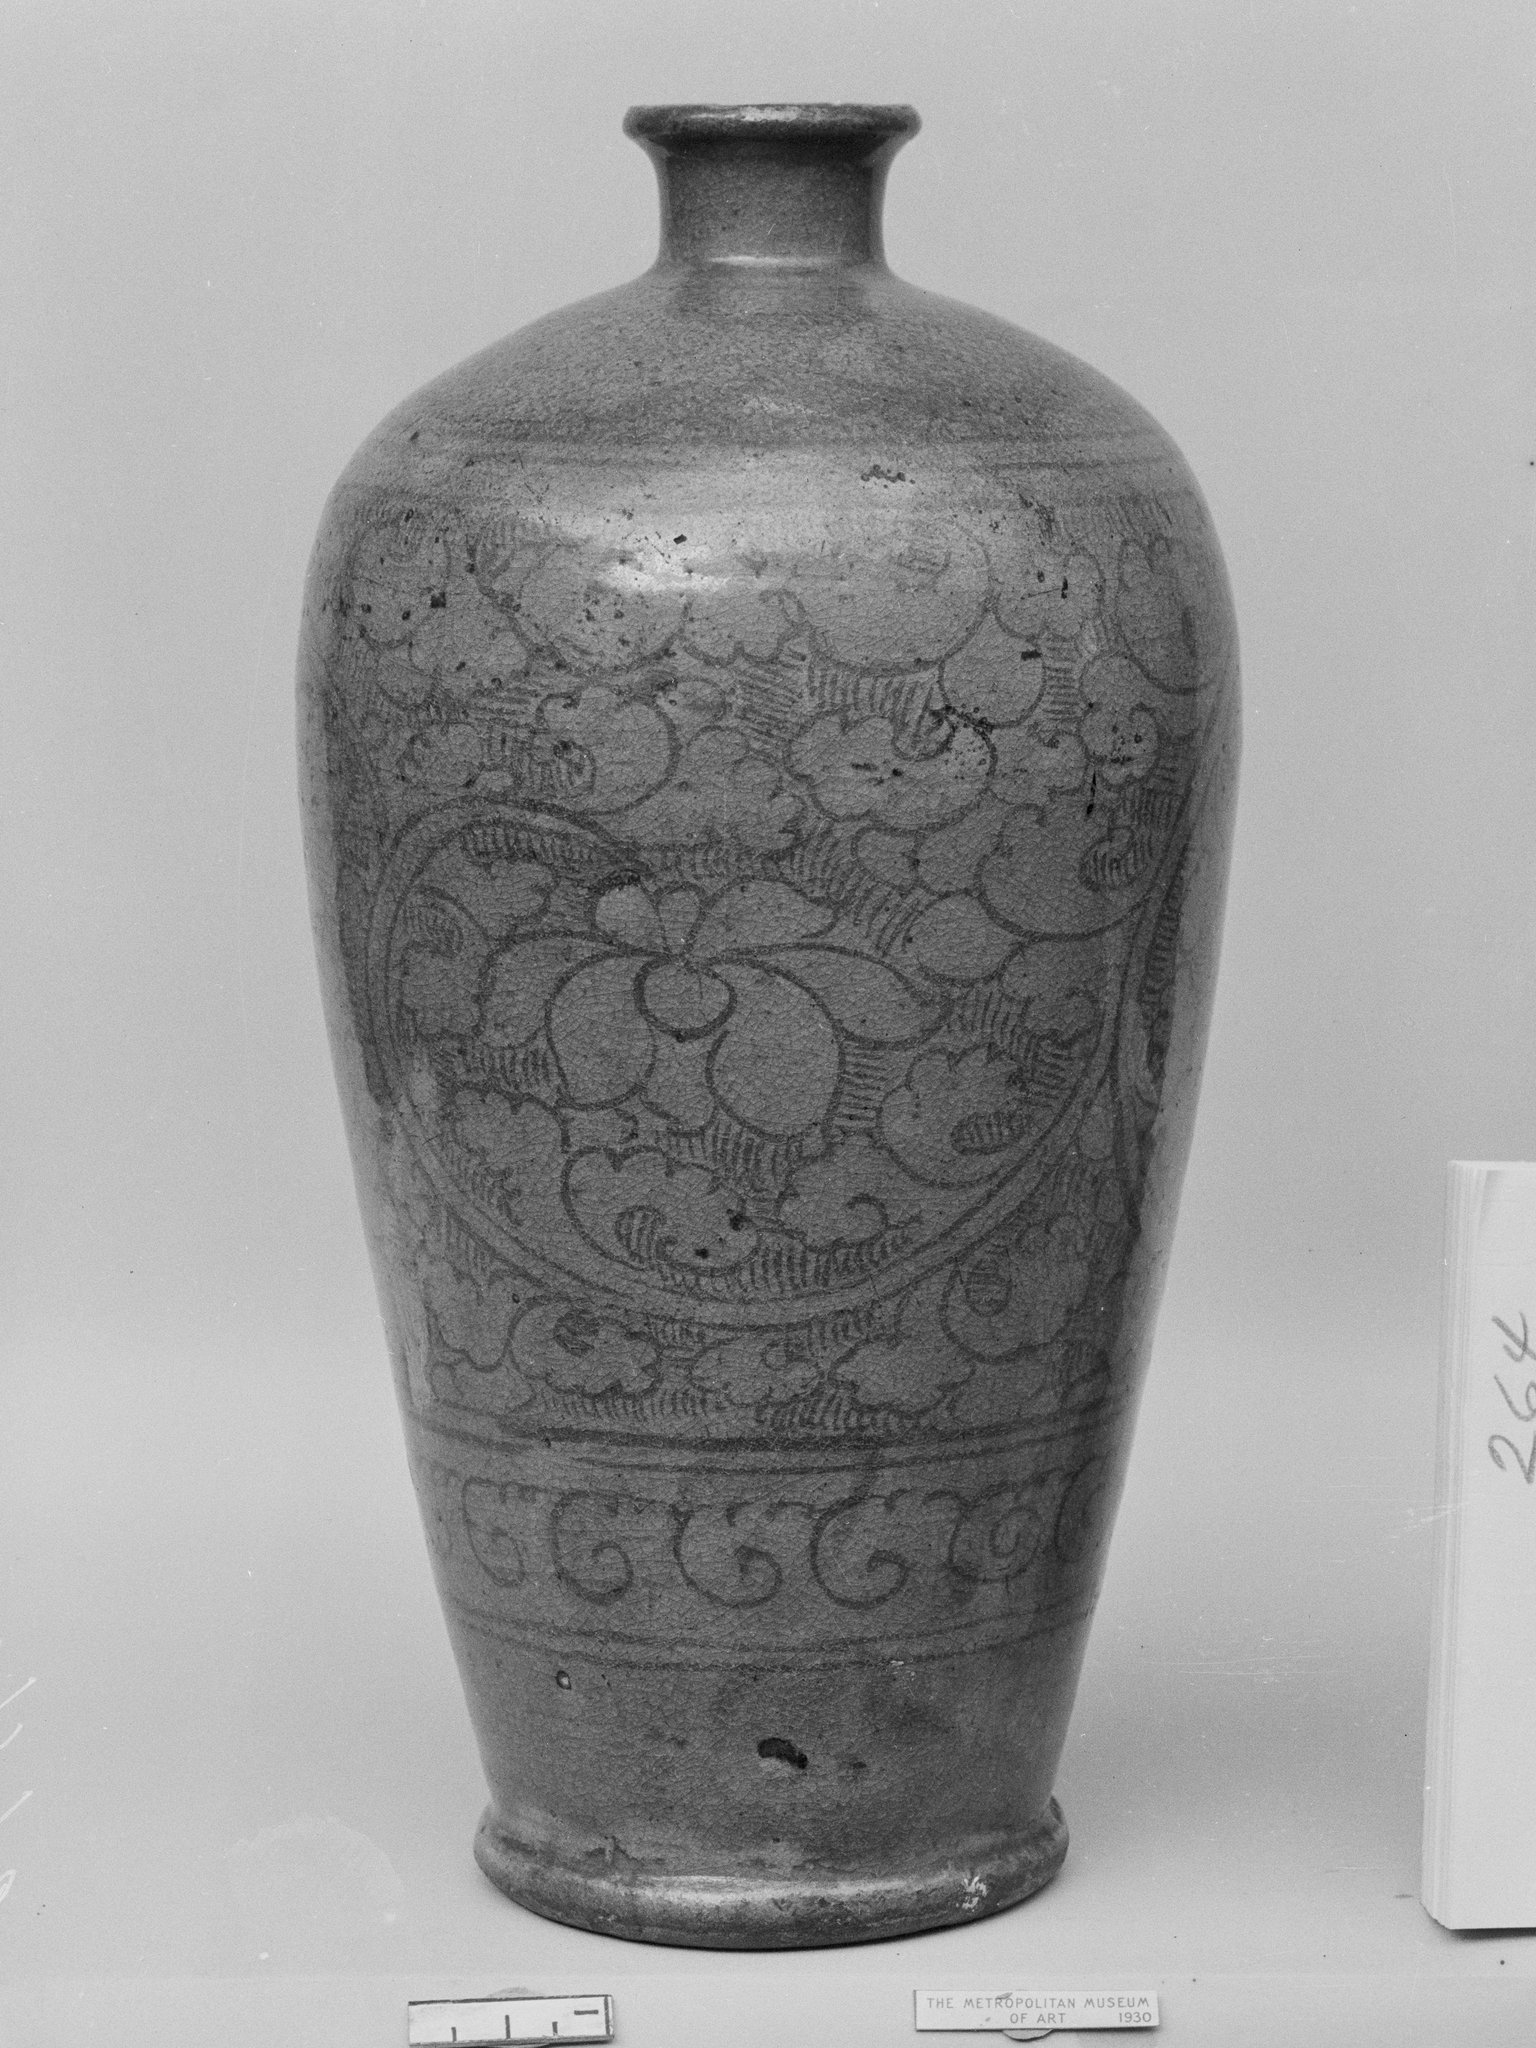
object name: vase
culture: chinese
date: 1271-1644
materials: stoneware